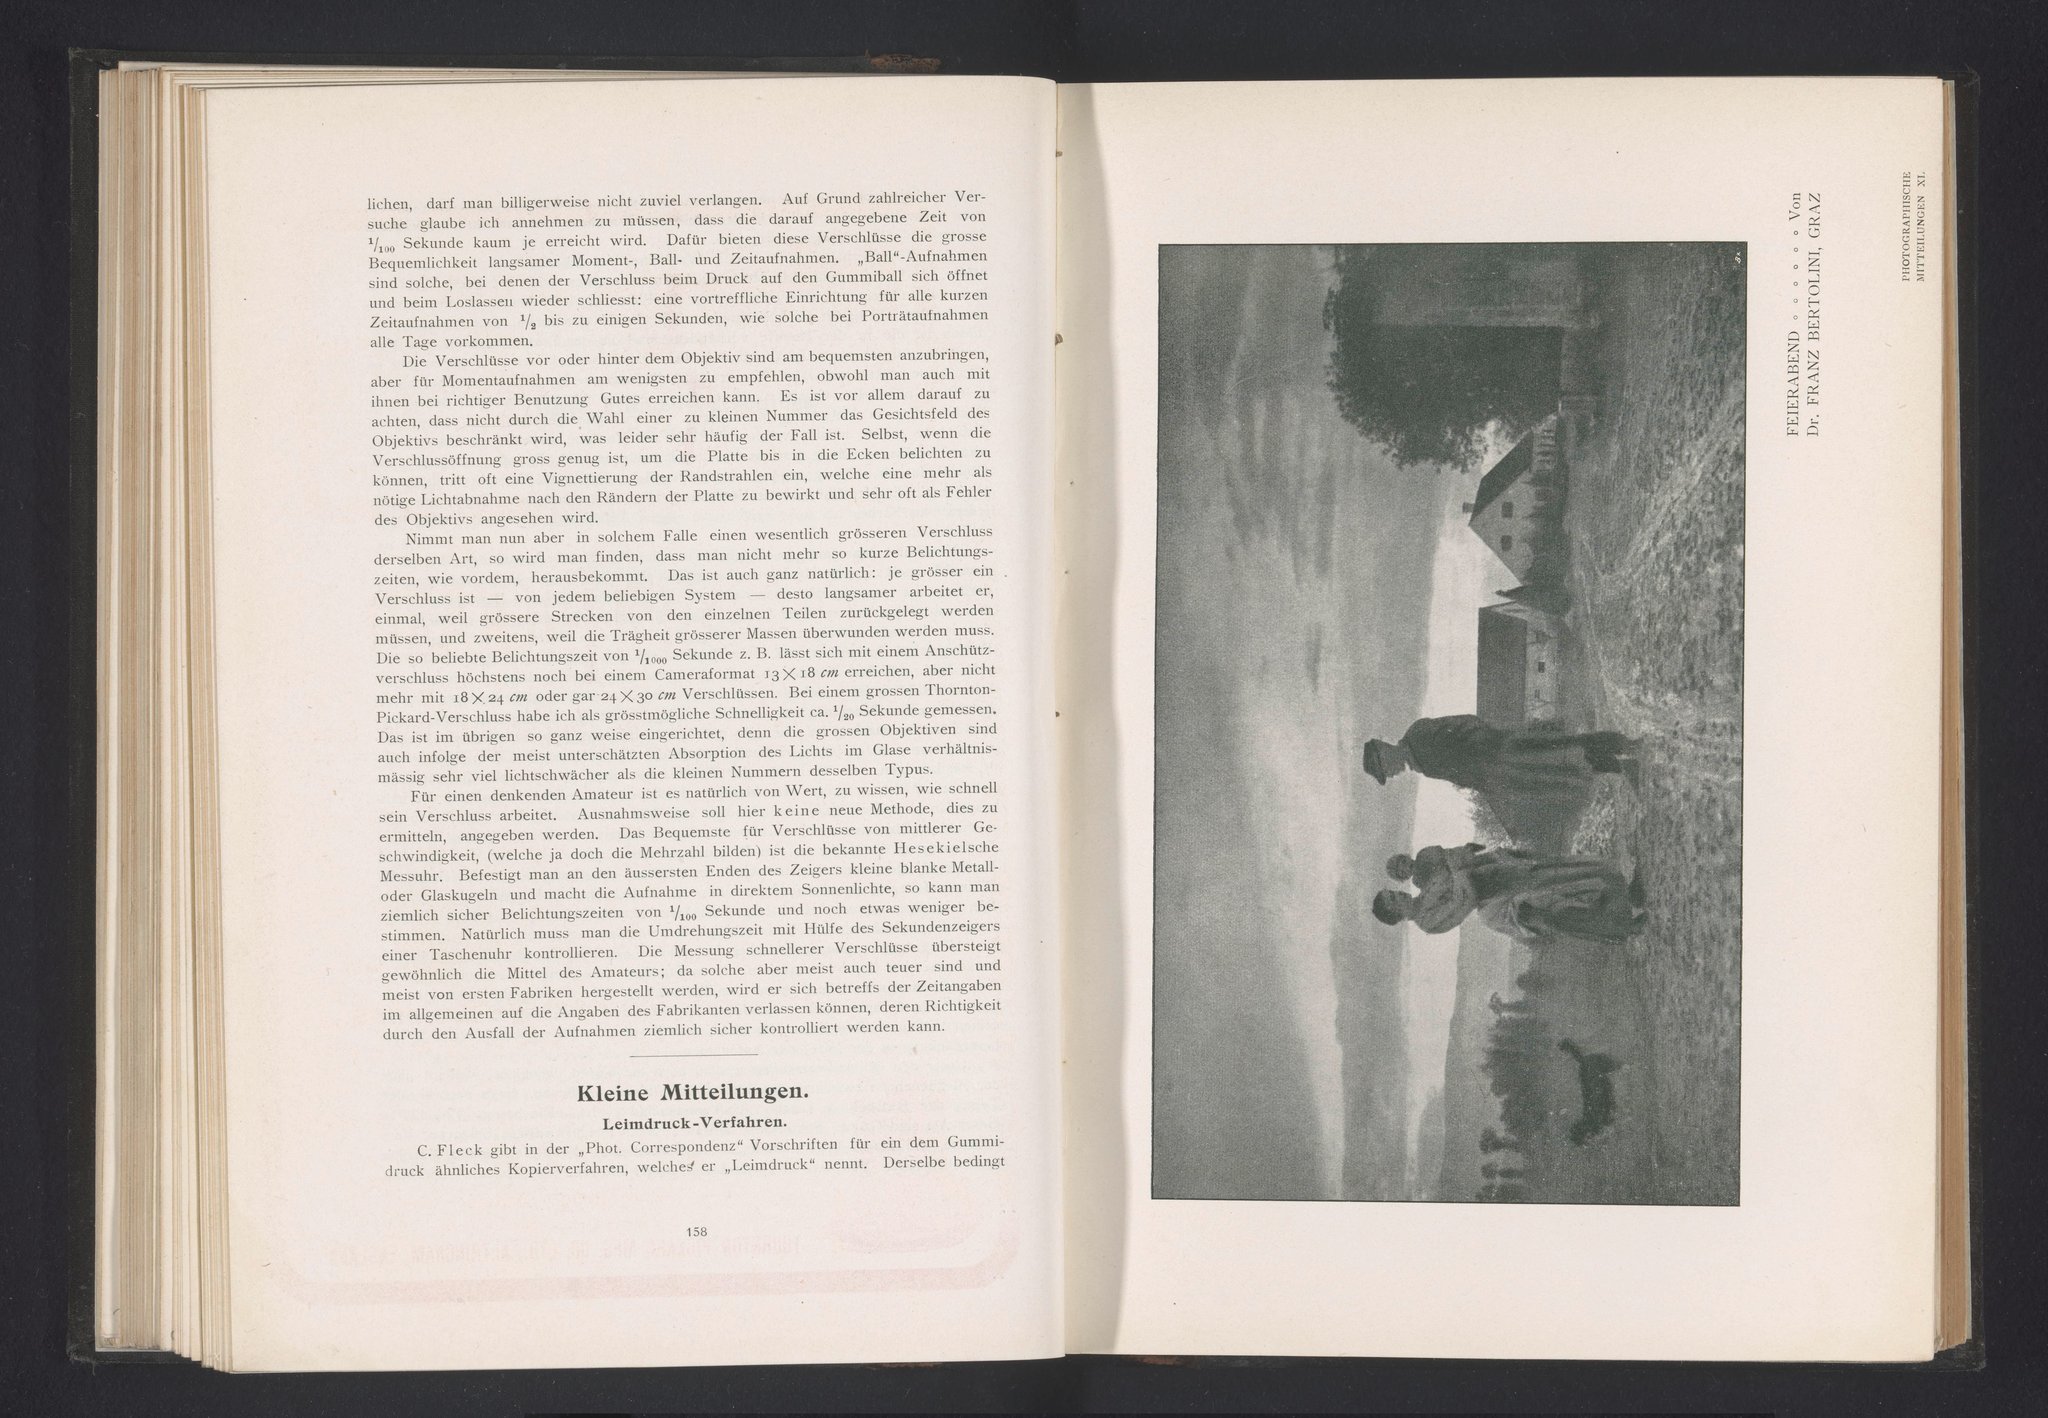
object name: page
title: Landschap met boerderij en gezin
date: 1898-1903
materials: paper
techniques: autotype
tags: landscapes, farm or solitary house in landscape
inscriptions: inscription: ‘Photographische Mitteilungen LX’, monogram: ‘BX’